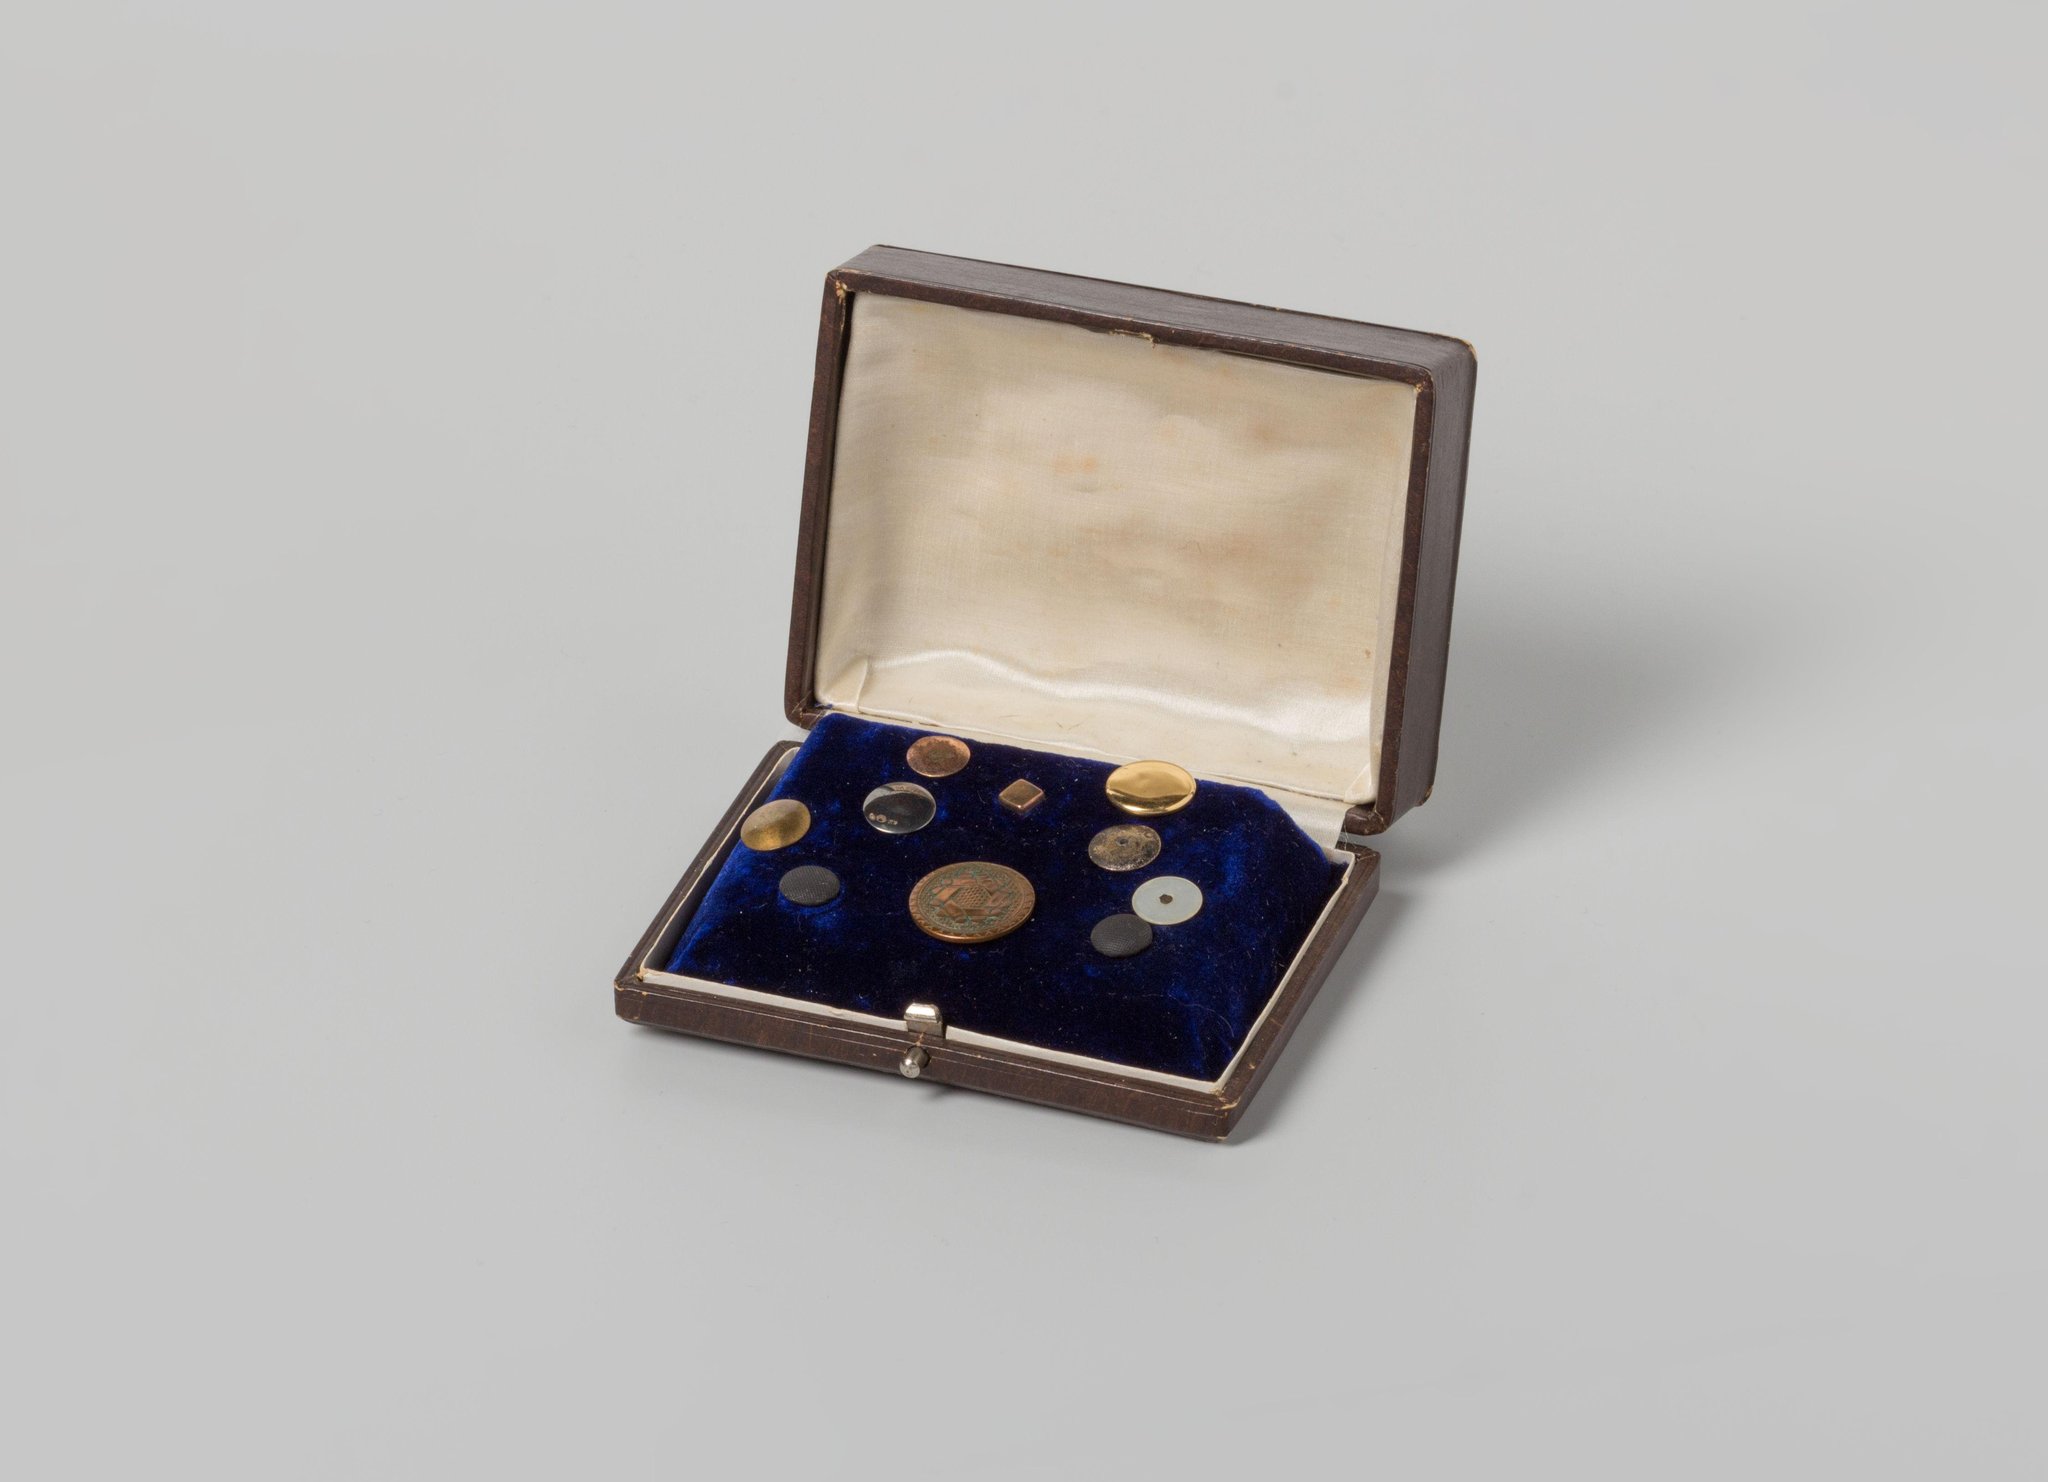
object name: menswear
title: Vierkante vestknoop of boordeknoop van koper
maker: Anonymous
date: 1900-1925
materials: copper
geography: western europe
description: Verzameling herenknoopen in zwart doosje. In niello zilver.